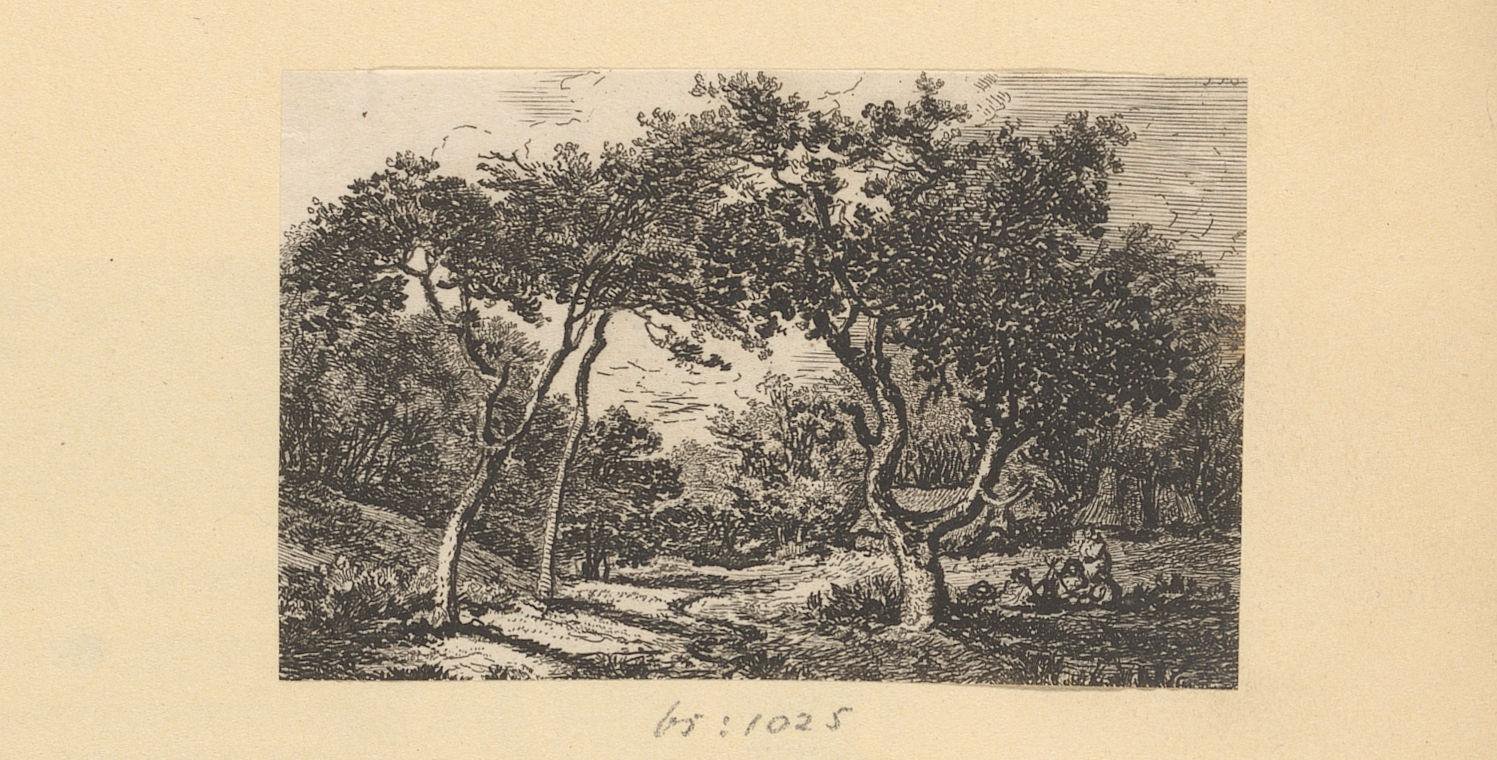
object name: album leaf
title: Landschap met bomen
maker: john smith of chichester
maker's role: print maker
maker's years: 1717-1764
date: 1727-1764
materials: paper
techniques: etching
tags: forest, wood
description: Prent maakt mogelijk deel uit van een serie van 200 prenten. Deze serie is onder de titel 'A Collection of two hundred original etchings' voor het eerst uitgegeven door J.M. Greery in 1816.